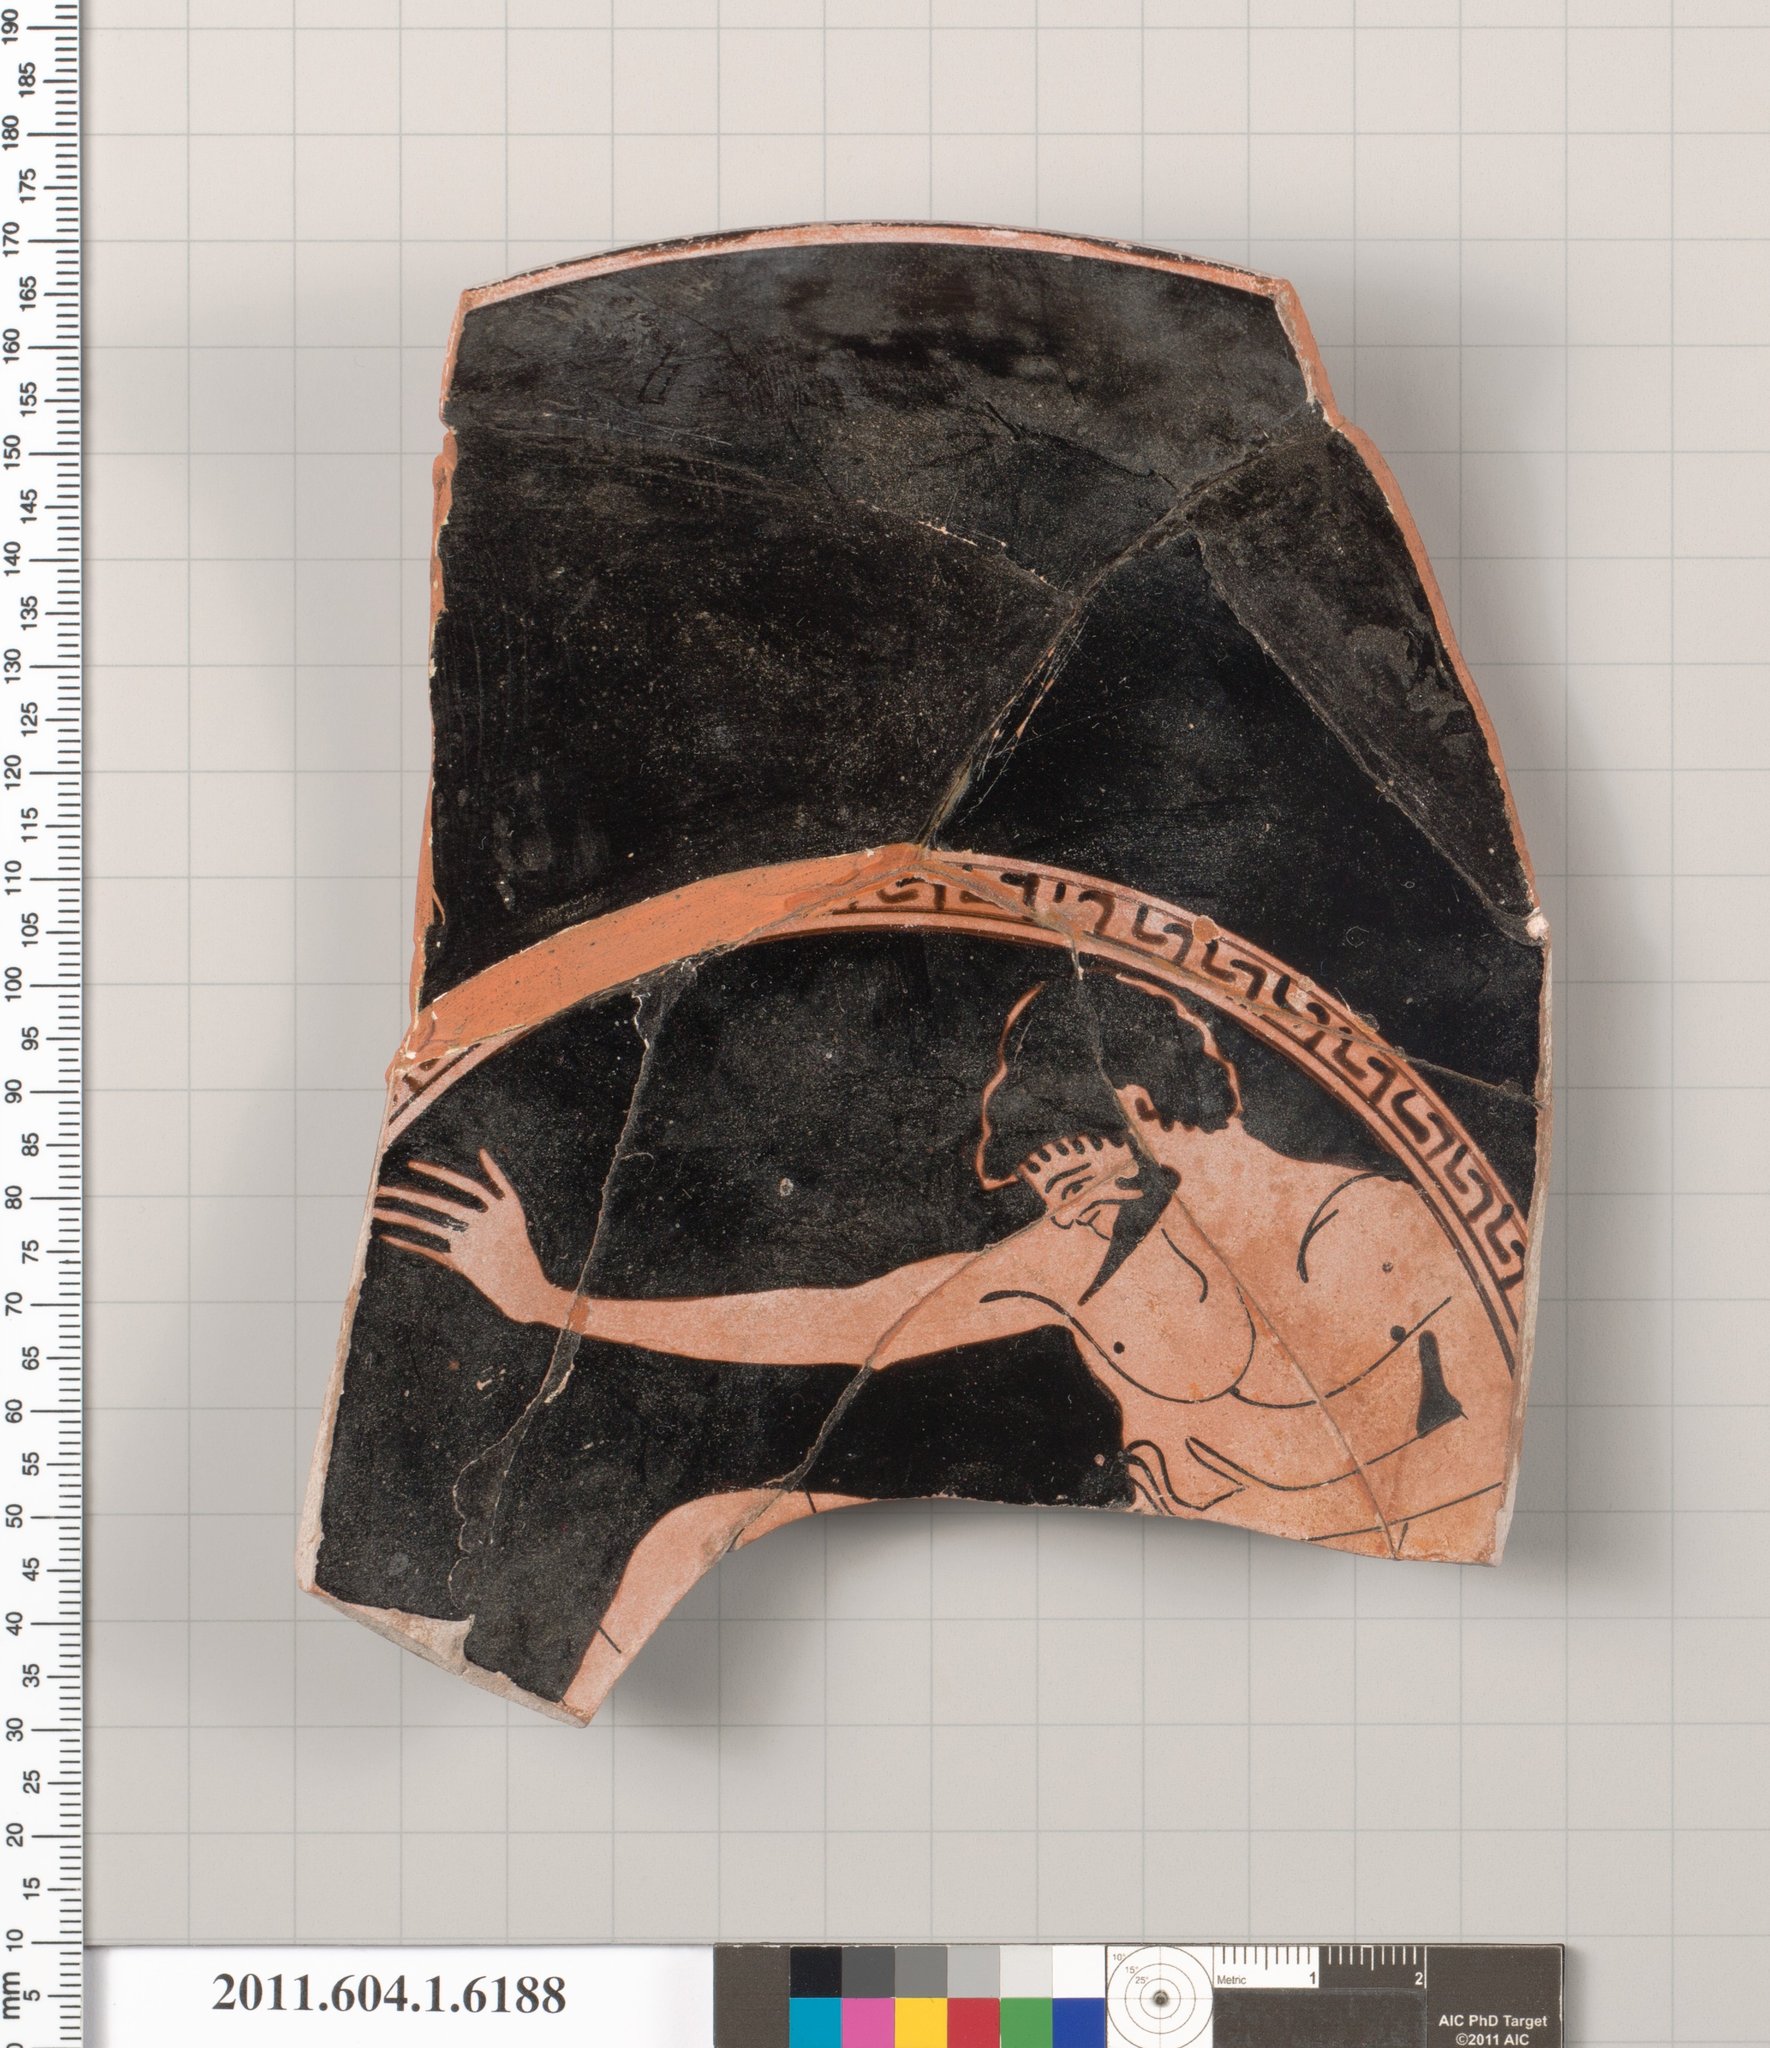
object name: kylix fragment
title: Terracotta fragment of a kylix (drinking cup)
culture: greek, attic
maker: painter of berlin 2268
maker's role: artist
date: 510-500 BCE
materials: terracotta